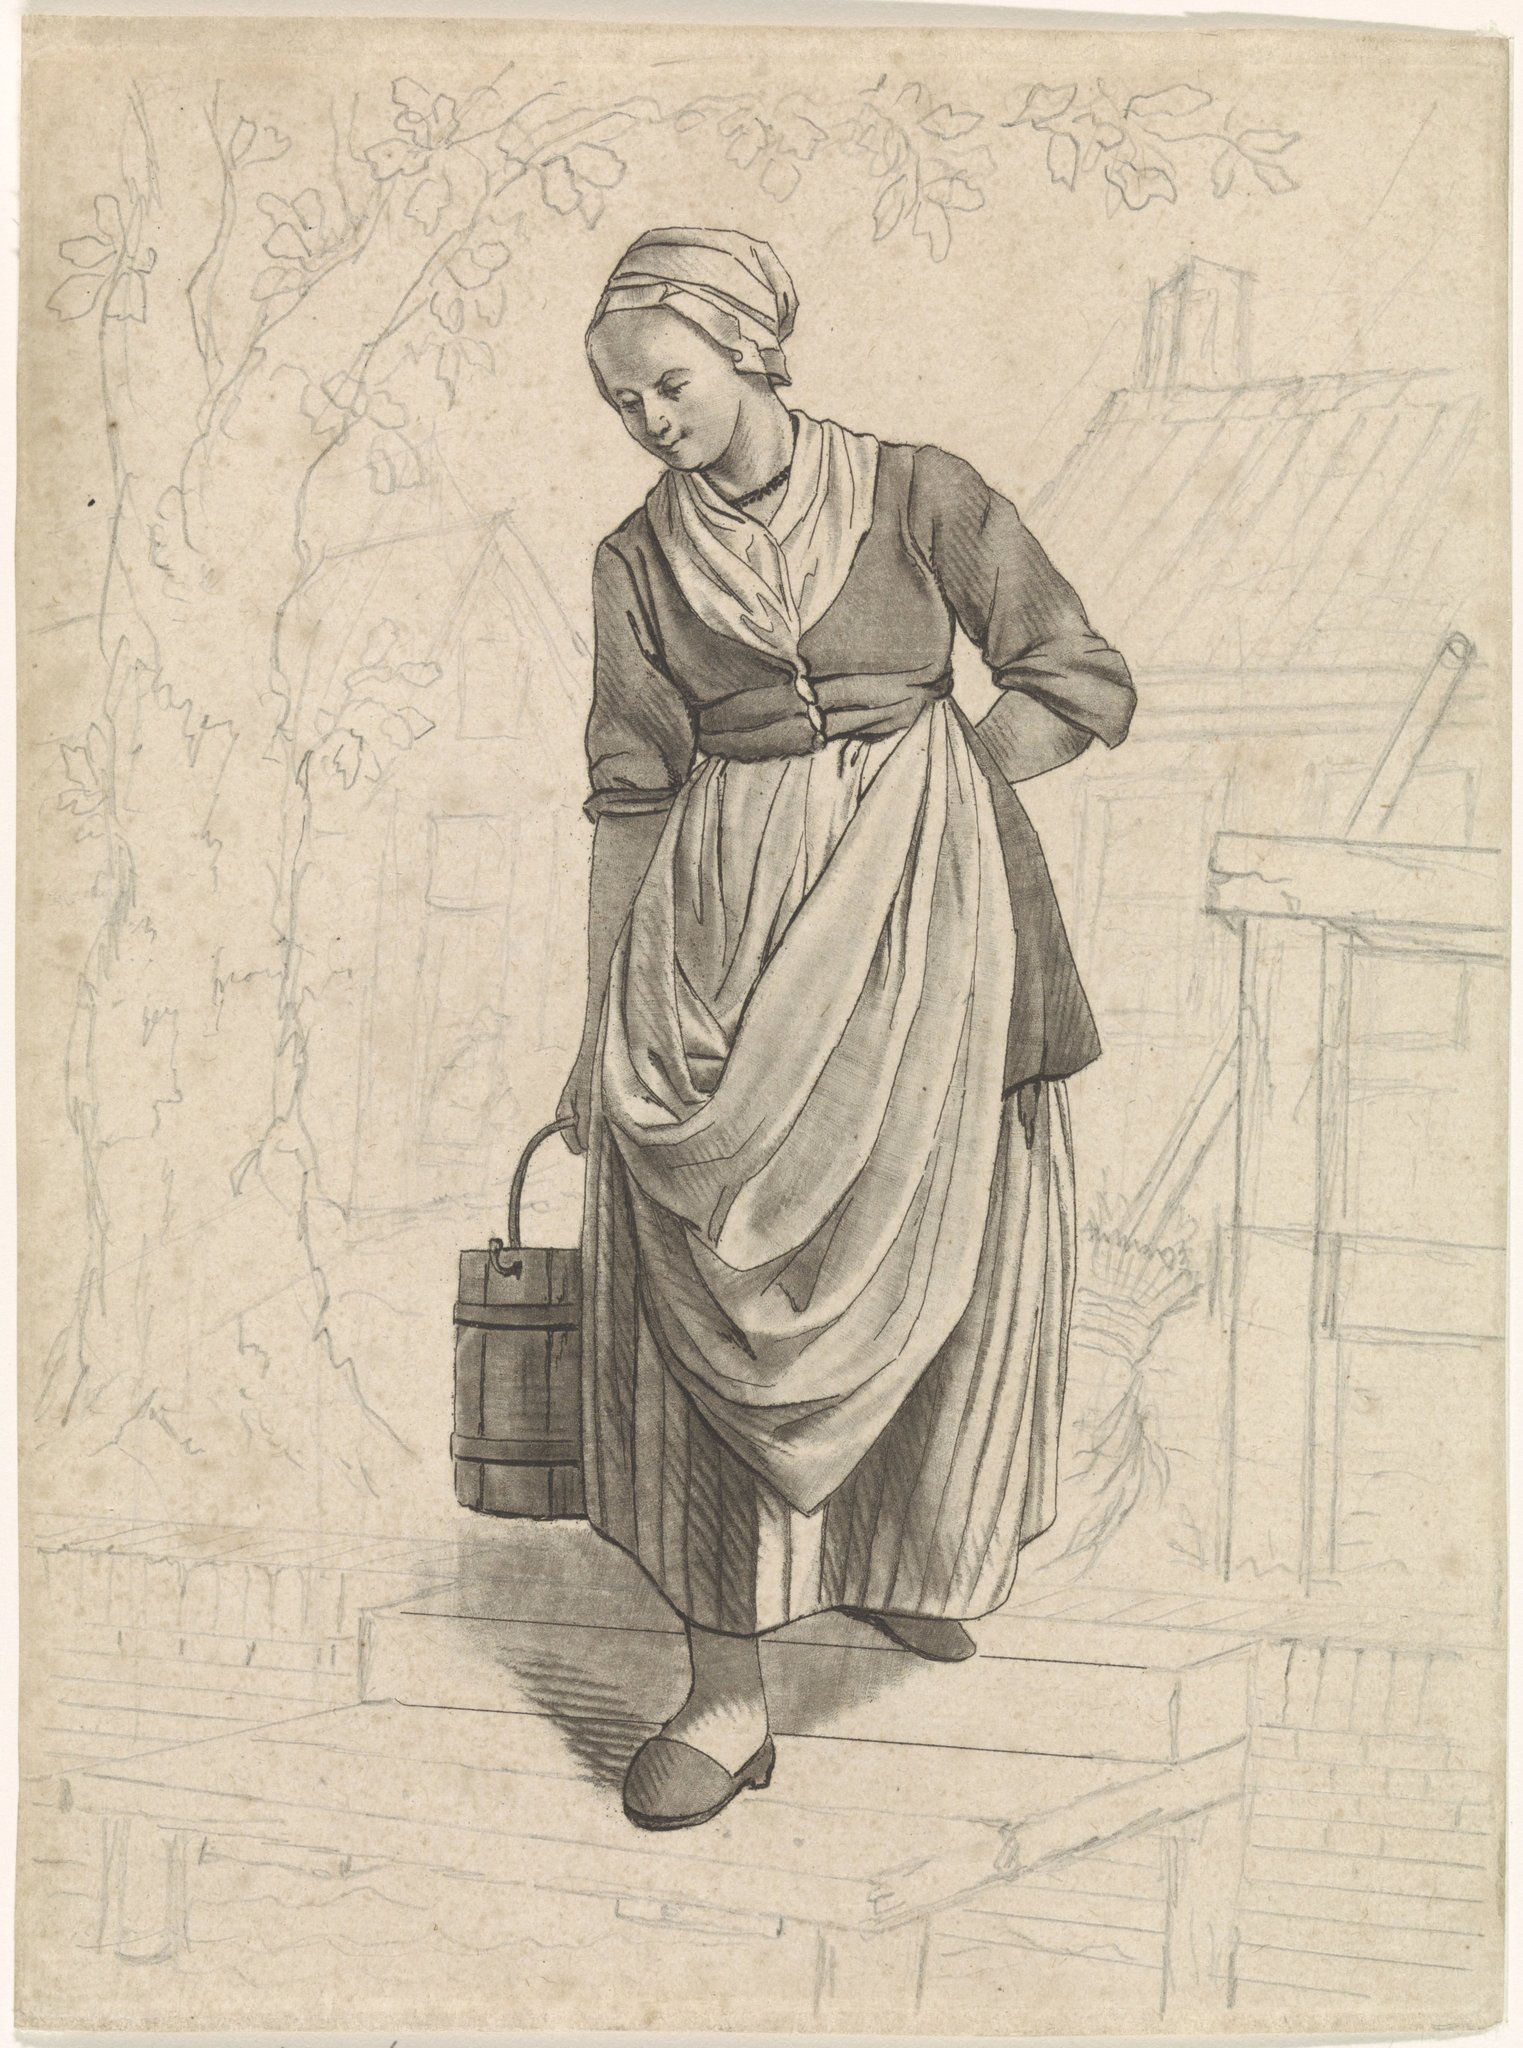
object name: print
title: Melkmeisje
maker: mathias de sallieth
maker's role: print maker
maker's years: 1749-1791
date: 1772-1791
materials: paper, pencil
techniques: aquatint, printmaking, etching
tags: milkmaid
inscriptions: collector's mark: Lugt 2228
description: De prent verscheen vanaf 1818 tevens als onderdeel van een 33-delige reeks prenten door Mathias de Sallieth, samengebonden in: Perkois, Jacobus, Prins, Johannes Huibert. Verzameling van verschillende gekleede mans- en vrouwenstanden, ter oefening van jonge schilders en liefhebbers. Rotterdam: Johannes Immerzeel, 1818.